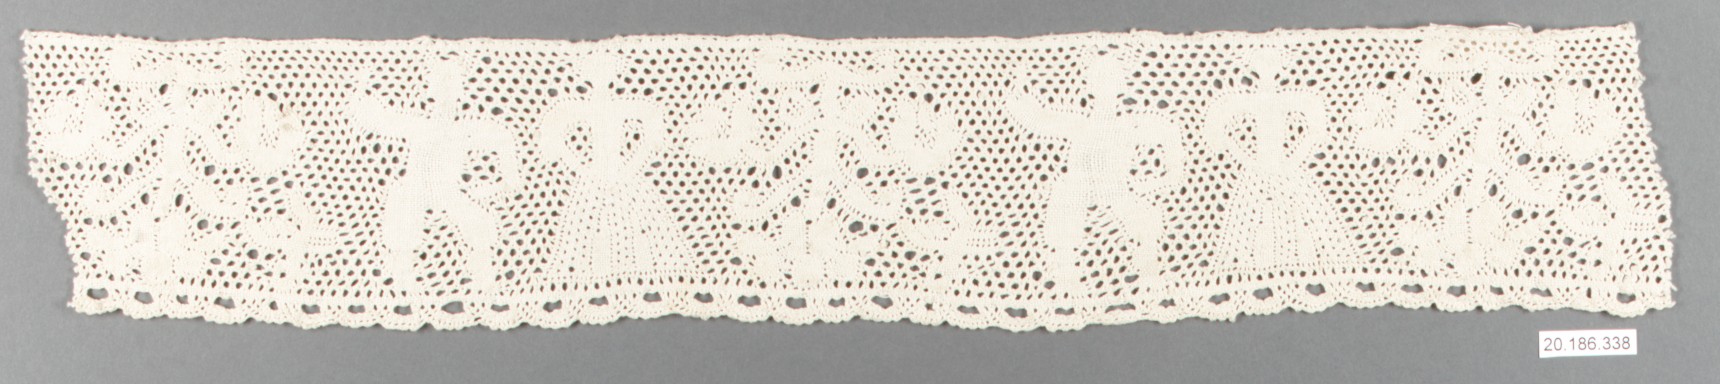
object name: edging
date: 1701-1800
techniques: lace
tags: human figures